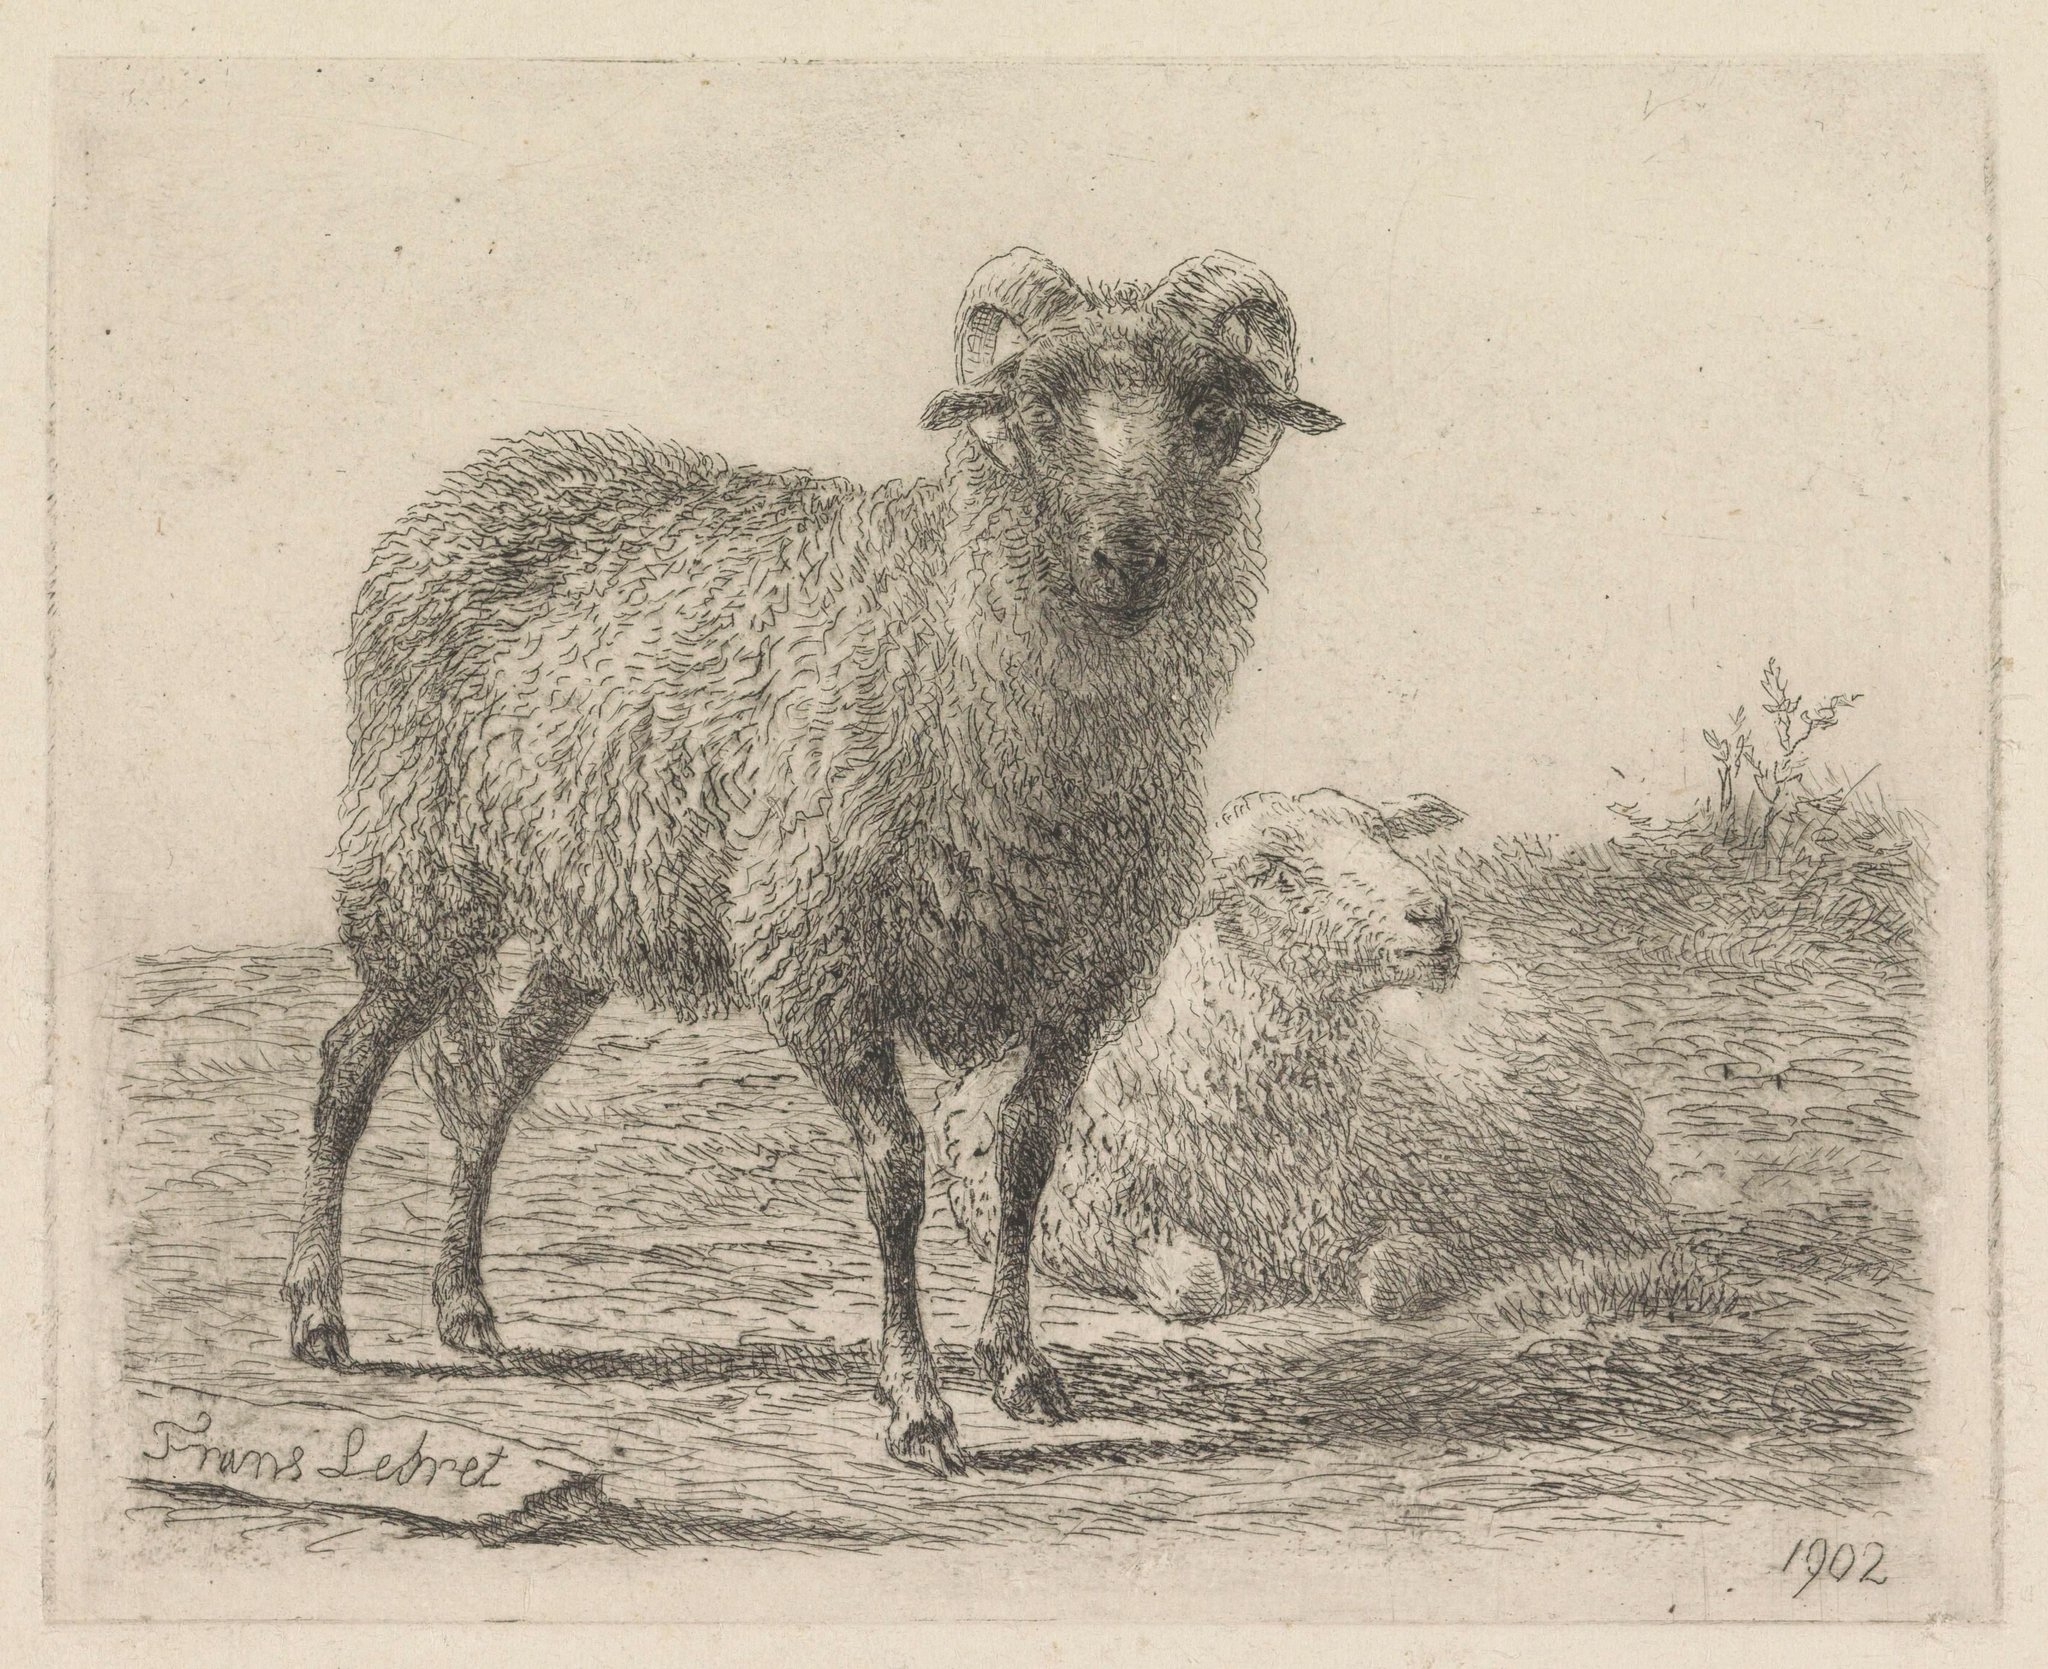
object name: print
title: Ram en schaap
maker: frans lebret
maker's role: draughtsman, painter, print maker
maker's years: 1820-1909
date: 1902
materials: paper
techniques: etching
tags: ram, sheep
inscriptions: collector's mark: Lugt 2228